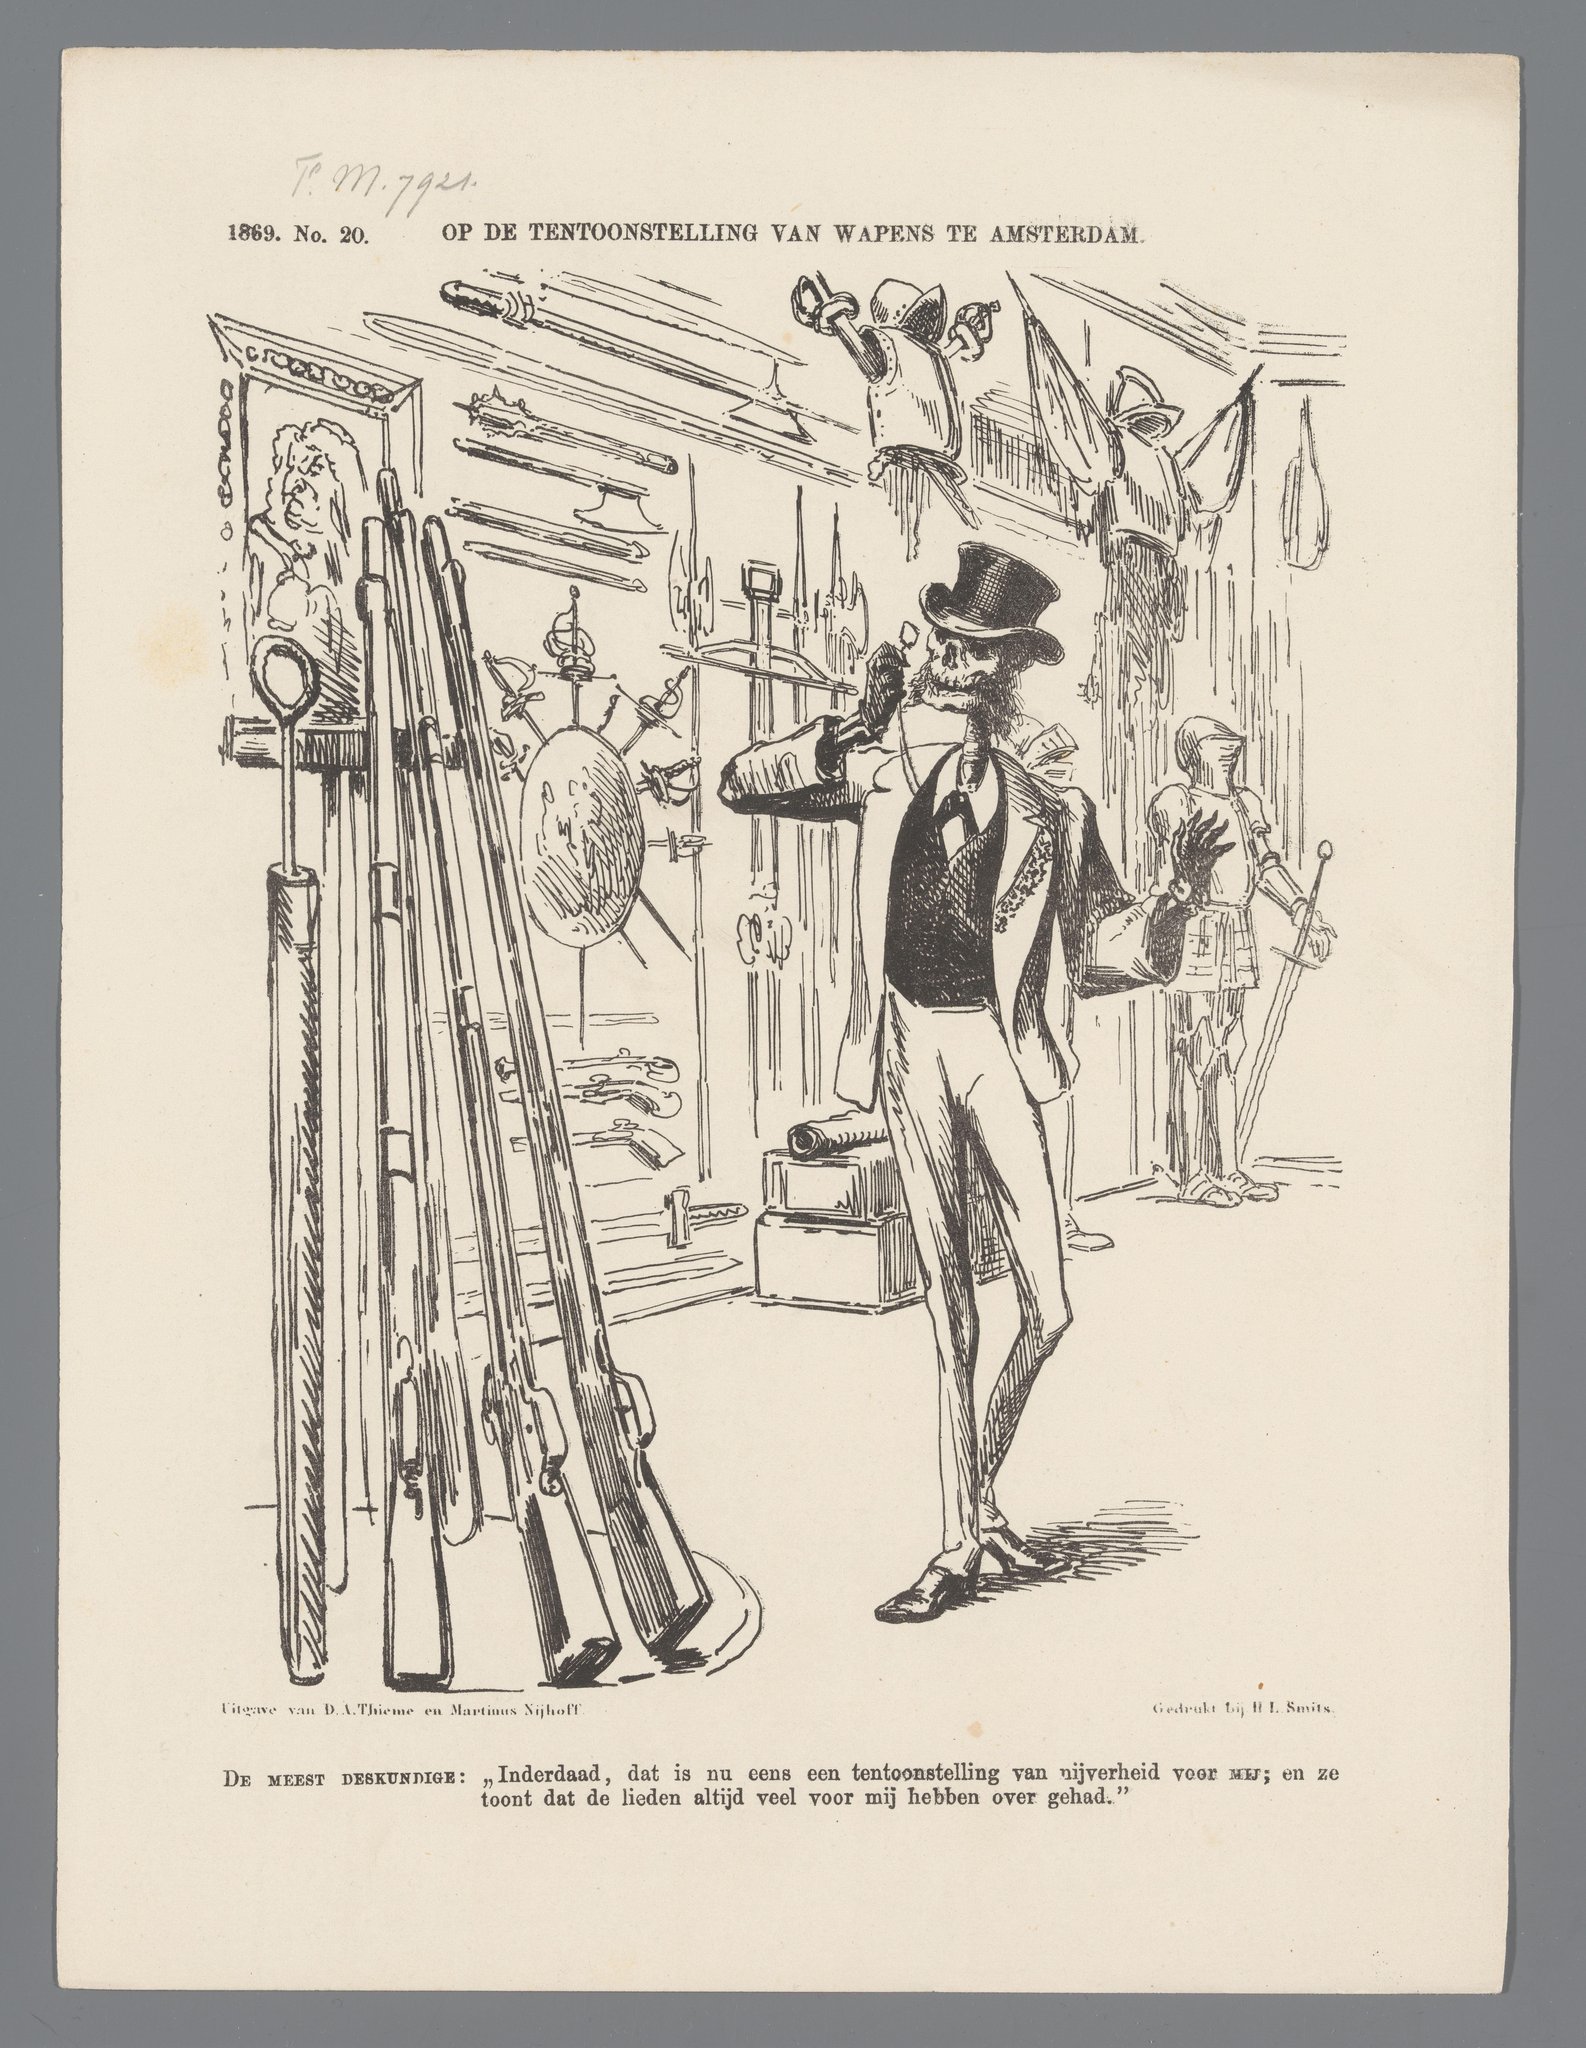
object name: cartoon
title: Op de tentoonstelling van wapens te Amsterdam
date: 1869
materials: paper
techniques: lithograph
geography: arnhem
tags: trade exhibition, industries fair, death as skeleton, weapons, amsterdam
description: Spotprent op wapententoonstelling te Amsterdam. De Dood uit zijn genoegen op de tentoonstelling. Plaat verschenen bij het weekblad De Nederlandsche Spectator, nr. 20, 1869.